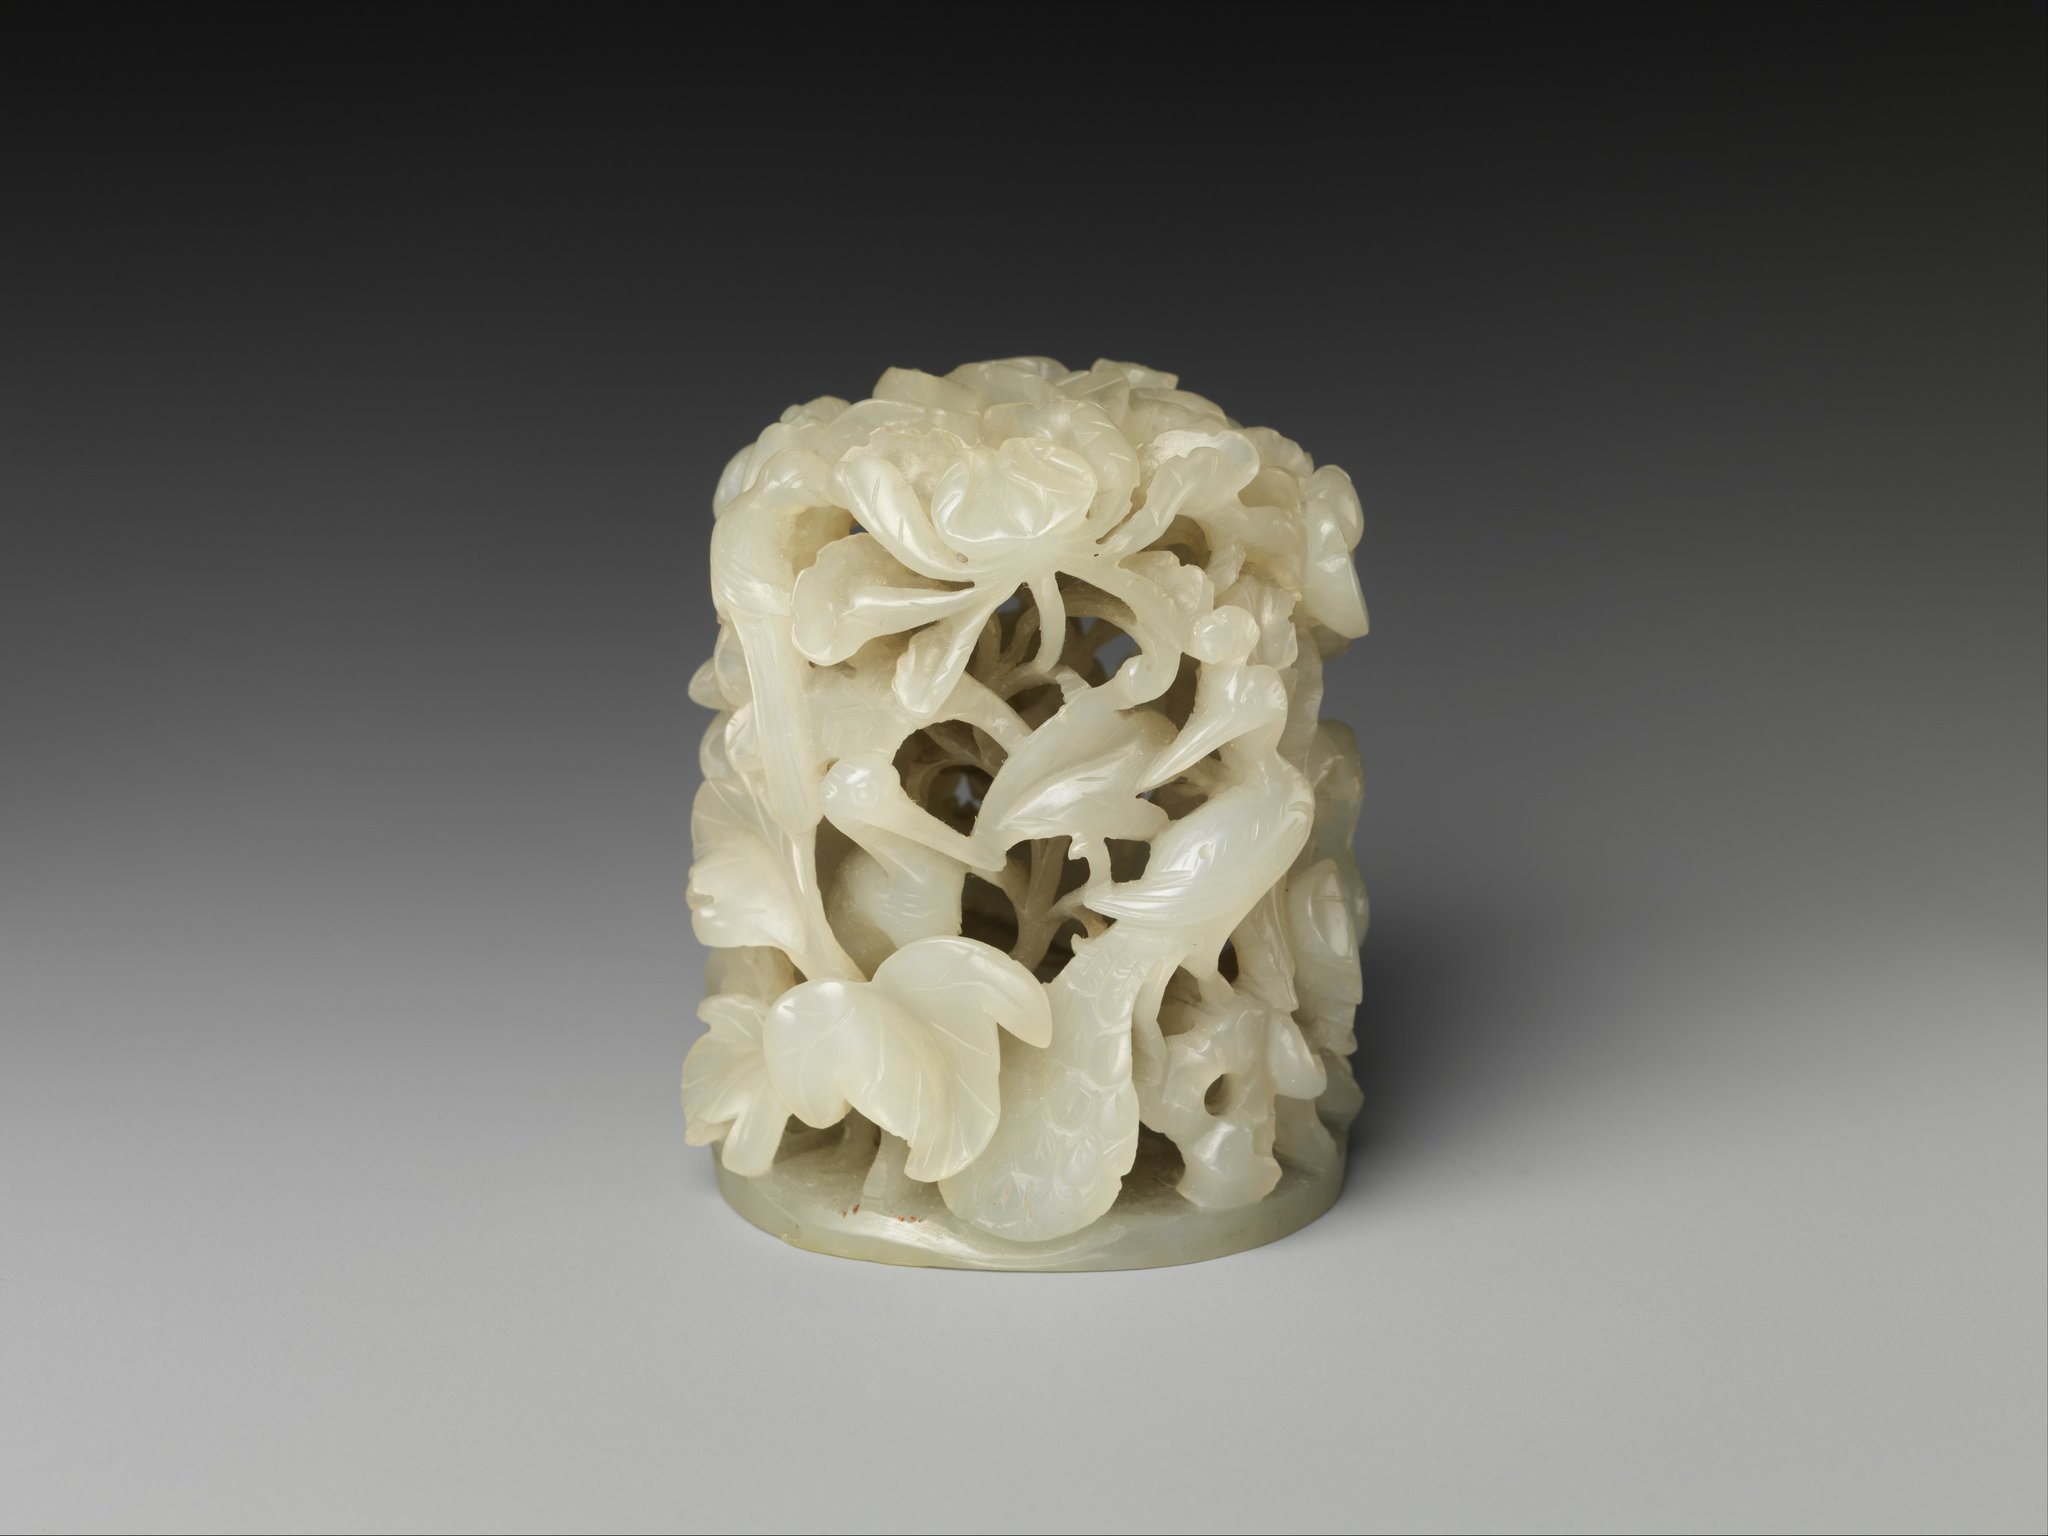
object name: headdress ornament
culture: chinese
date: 1201-1300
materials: jade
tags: leaves